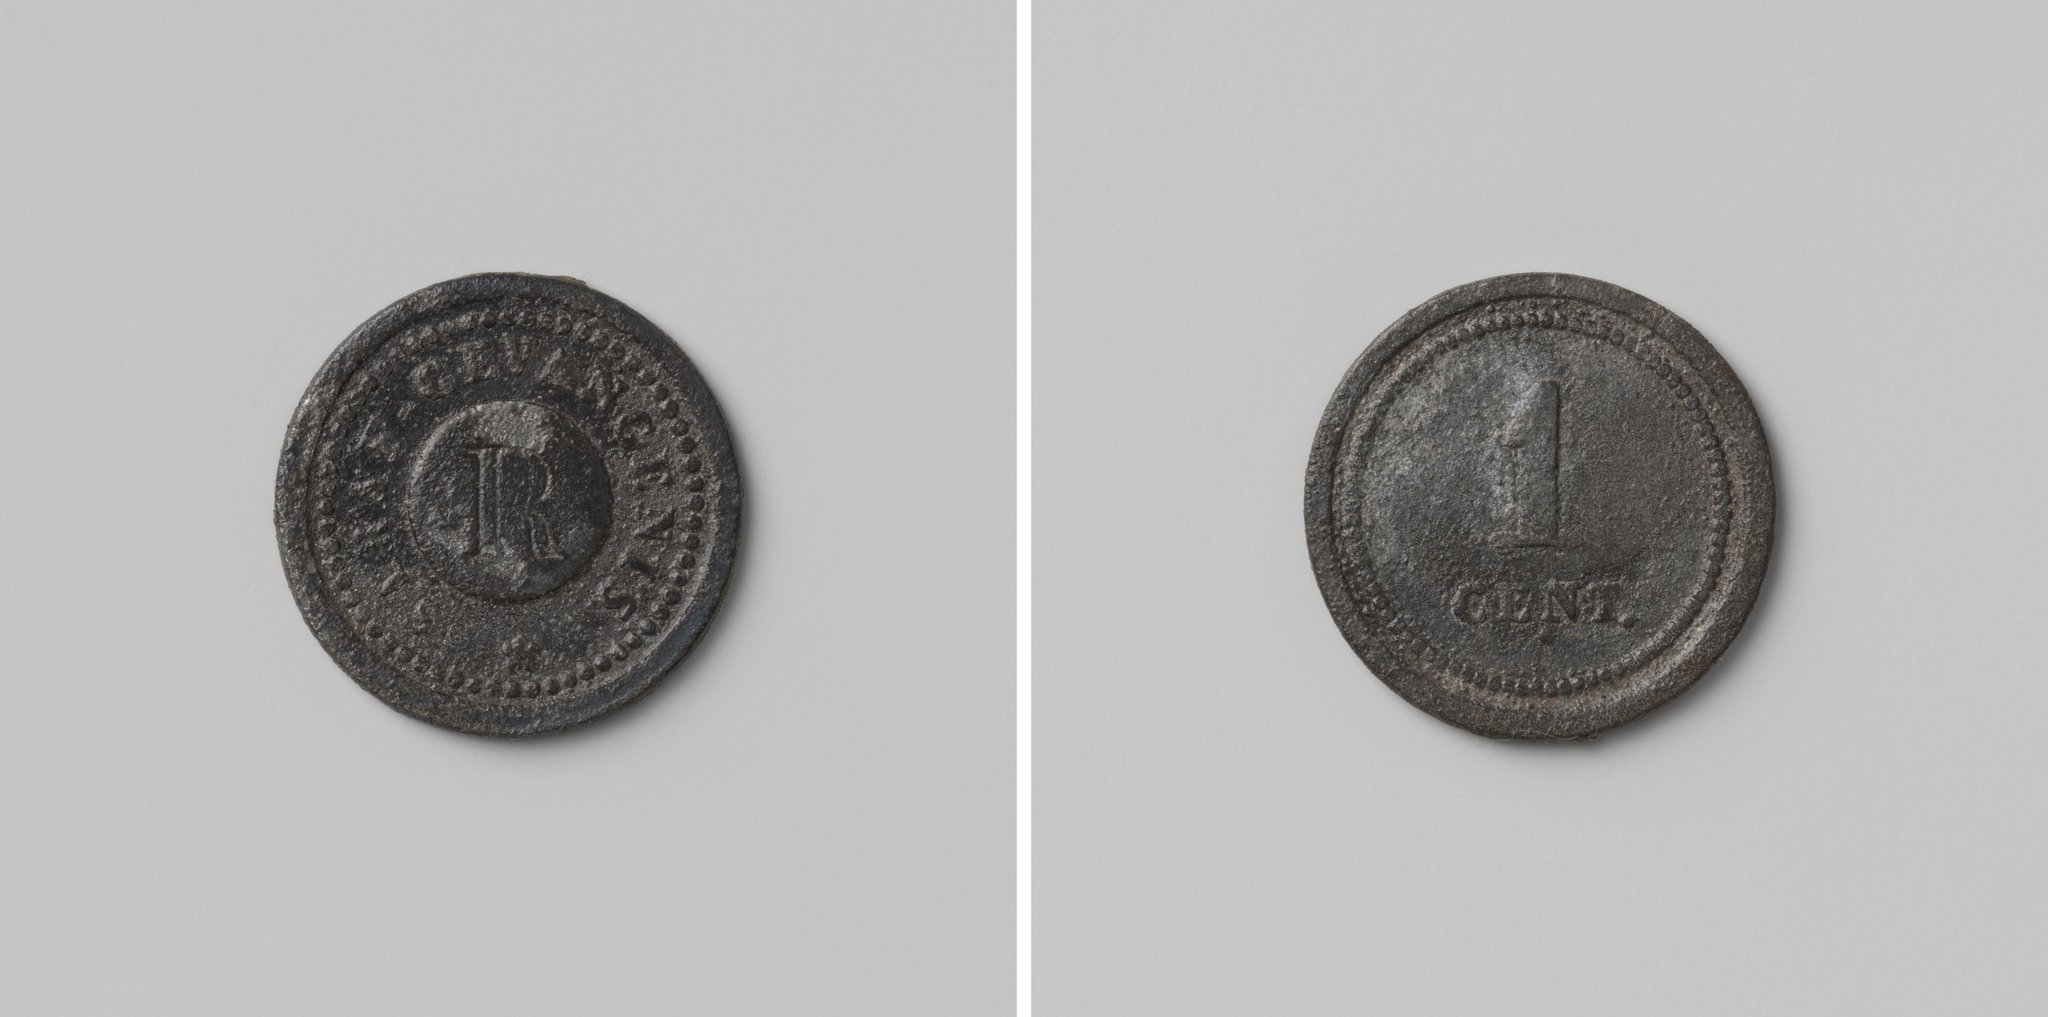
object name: huismunt prison money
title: Strafgevangenis te Rotterdam, huismunt ter waarde van een cent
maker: Anonymous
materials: zinc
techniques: striking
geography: utrecht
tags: rotterdam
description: Zinken betaalpenning. Voorzijde: letter R binnen omschrift. Keerzijde: waardeaanduiding